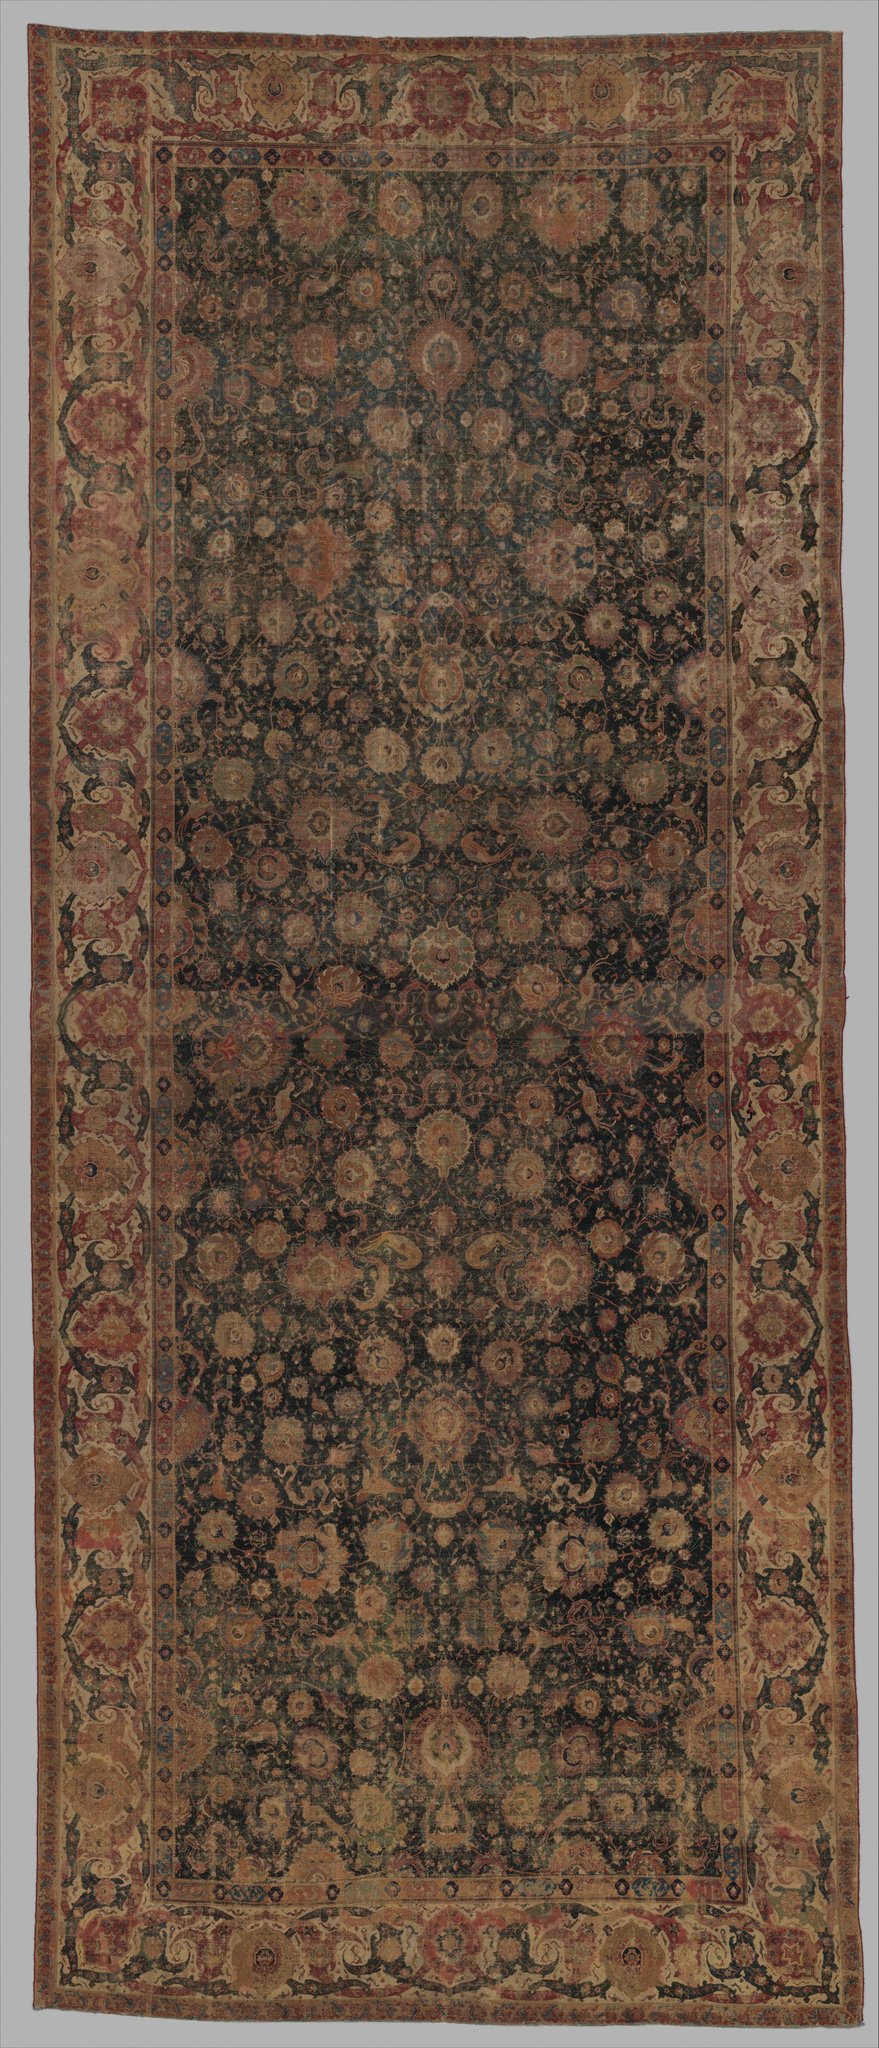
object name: carpet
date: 1567-1600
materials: cotton, wool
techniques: asymmetrically knotted pile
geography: iran